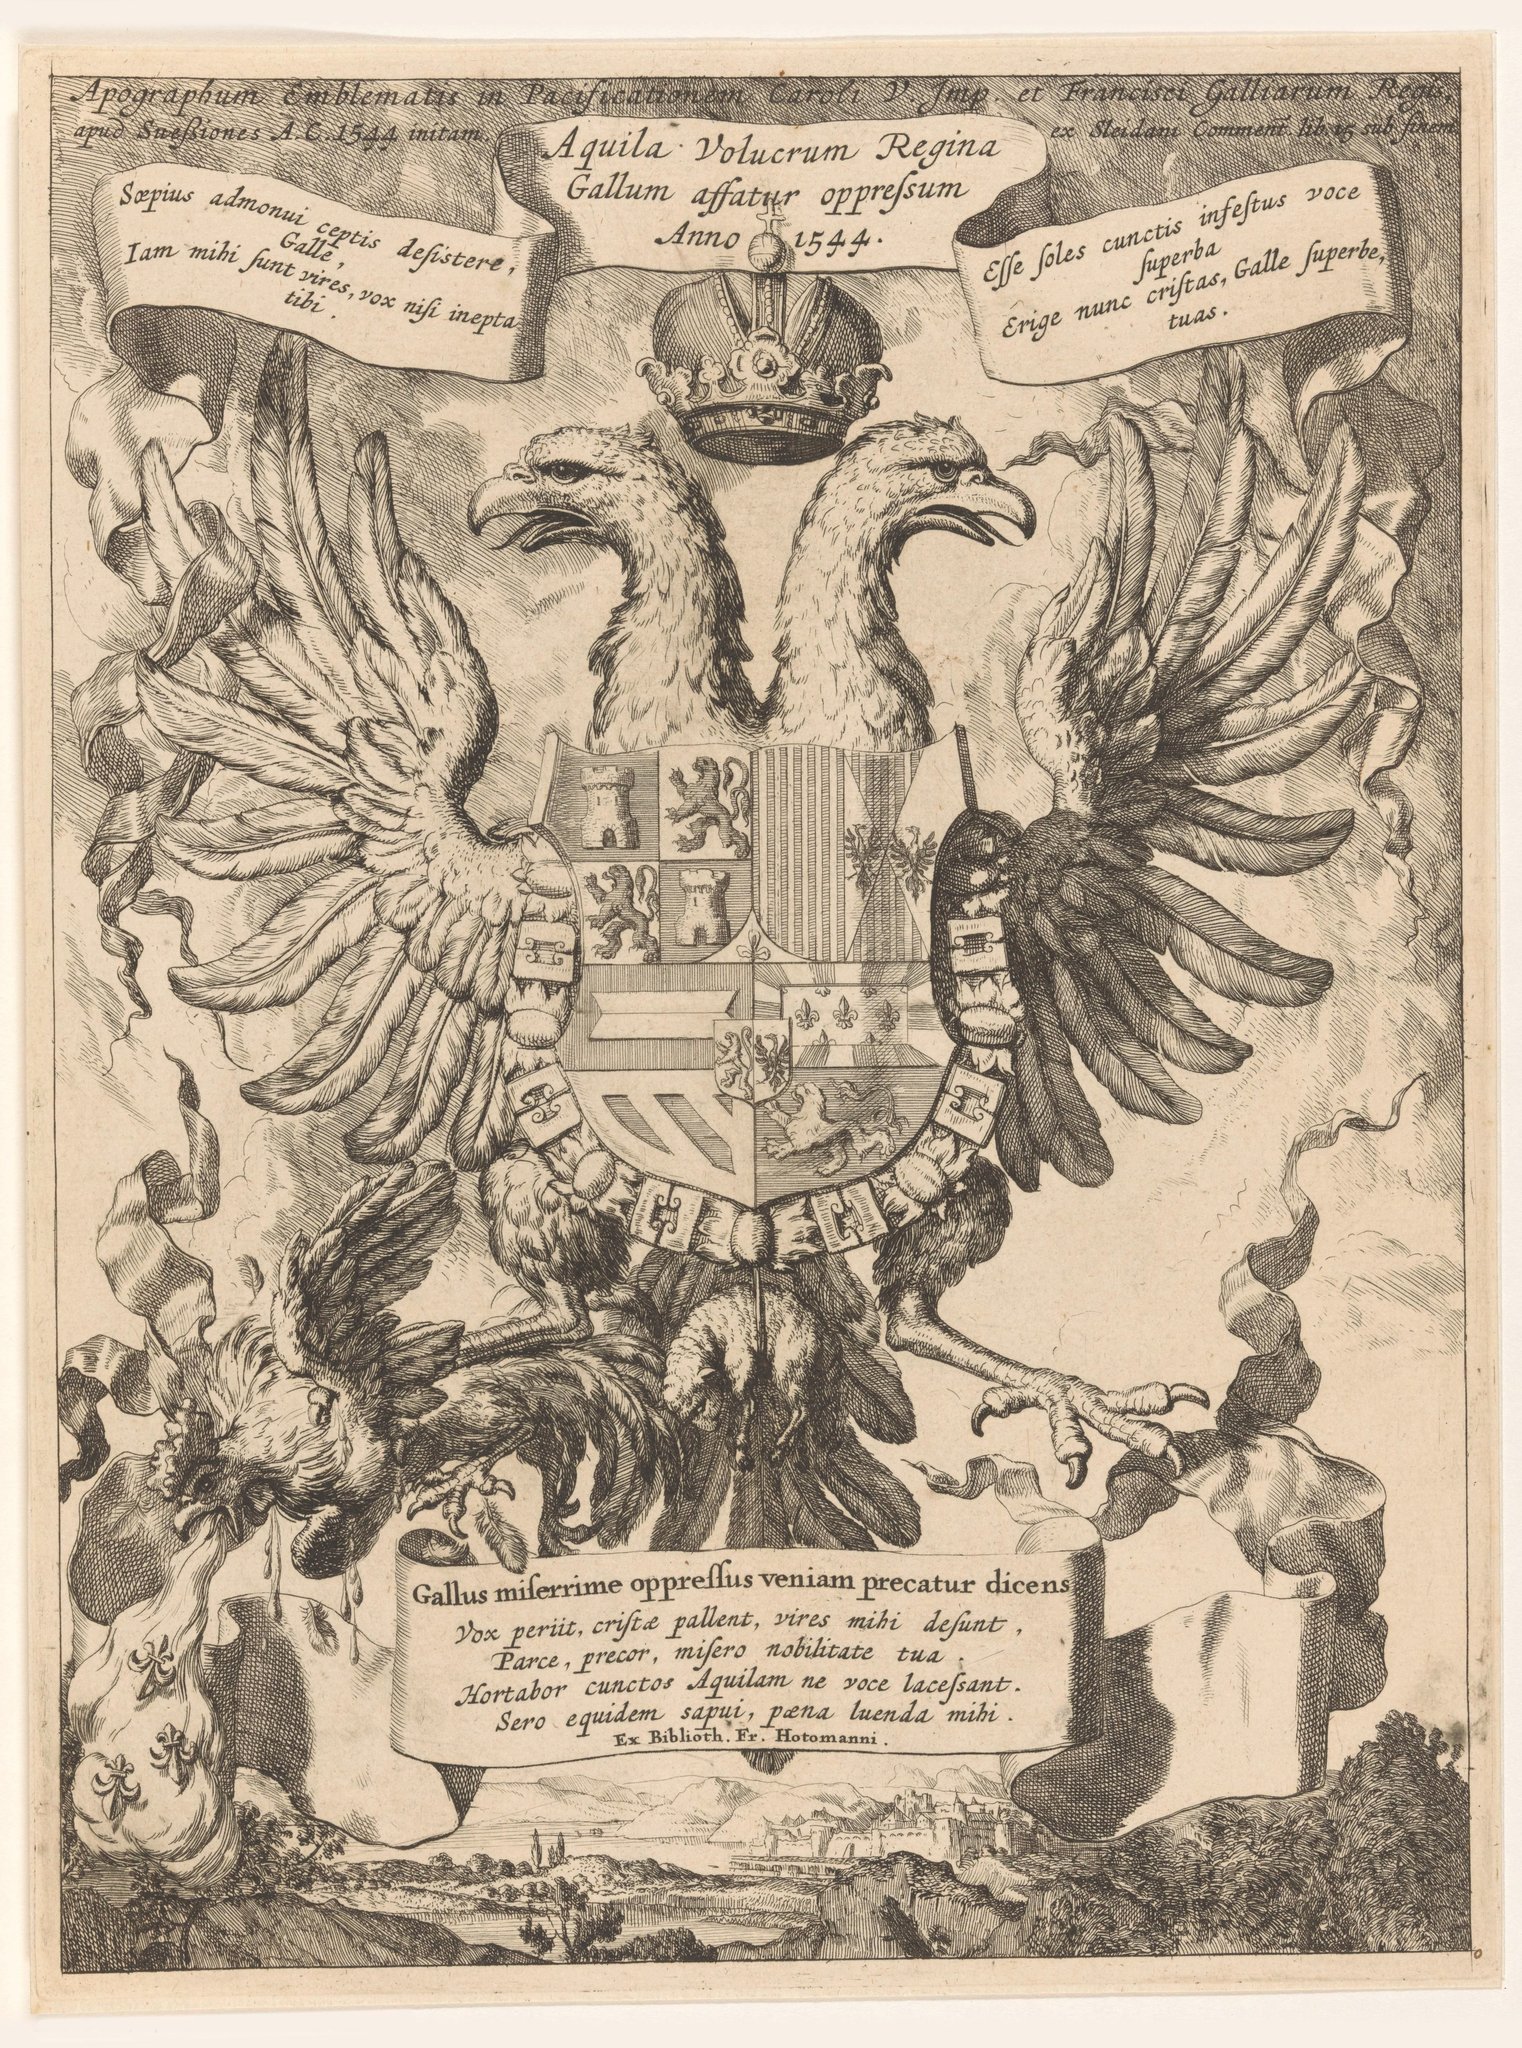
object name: print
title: Allegorie op de vrede van Crépy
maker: gerard de lairesse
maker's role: draughtsman, painter, print maker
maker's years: 1641-1711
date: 1670-1680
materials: paper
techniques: etching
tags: double-headed eagle, symbols, allegories of peace, 'pax'; 'pace' (ripa), knighthood order of the golden fleece, fowl (cock, hen, chicken, etc.), armorial bearing, heraldry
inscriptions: collector's mark: Lugt 2760, collector's mark: Lugt 2228, collector's mark: ‘L.A. de Vries’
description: Allegorie op de Vrede van Crépy, gesloten op 18 september 1544 in Crépy tussen Frans I van Frankrijk en Karel V van het Heilige Roomse Rijk. Een wapenschild is omhangen met de Orde van het Gulden Vlies en wordt vastgehouden door een gekroonde tweekoppige adelaar. In zijn rechter poot houdt de adelaar een haan vast die de Franse lelie uitspuugt. Boven en onder de adelaar staan banderollen met Latijnse tekst. Geheel onderin de prent een weergave van een landschap.